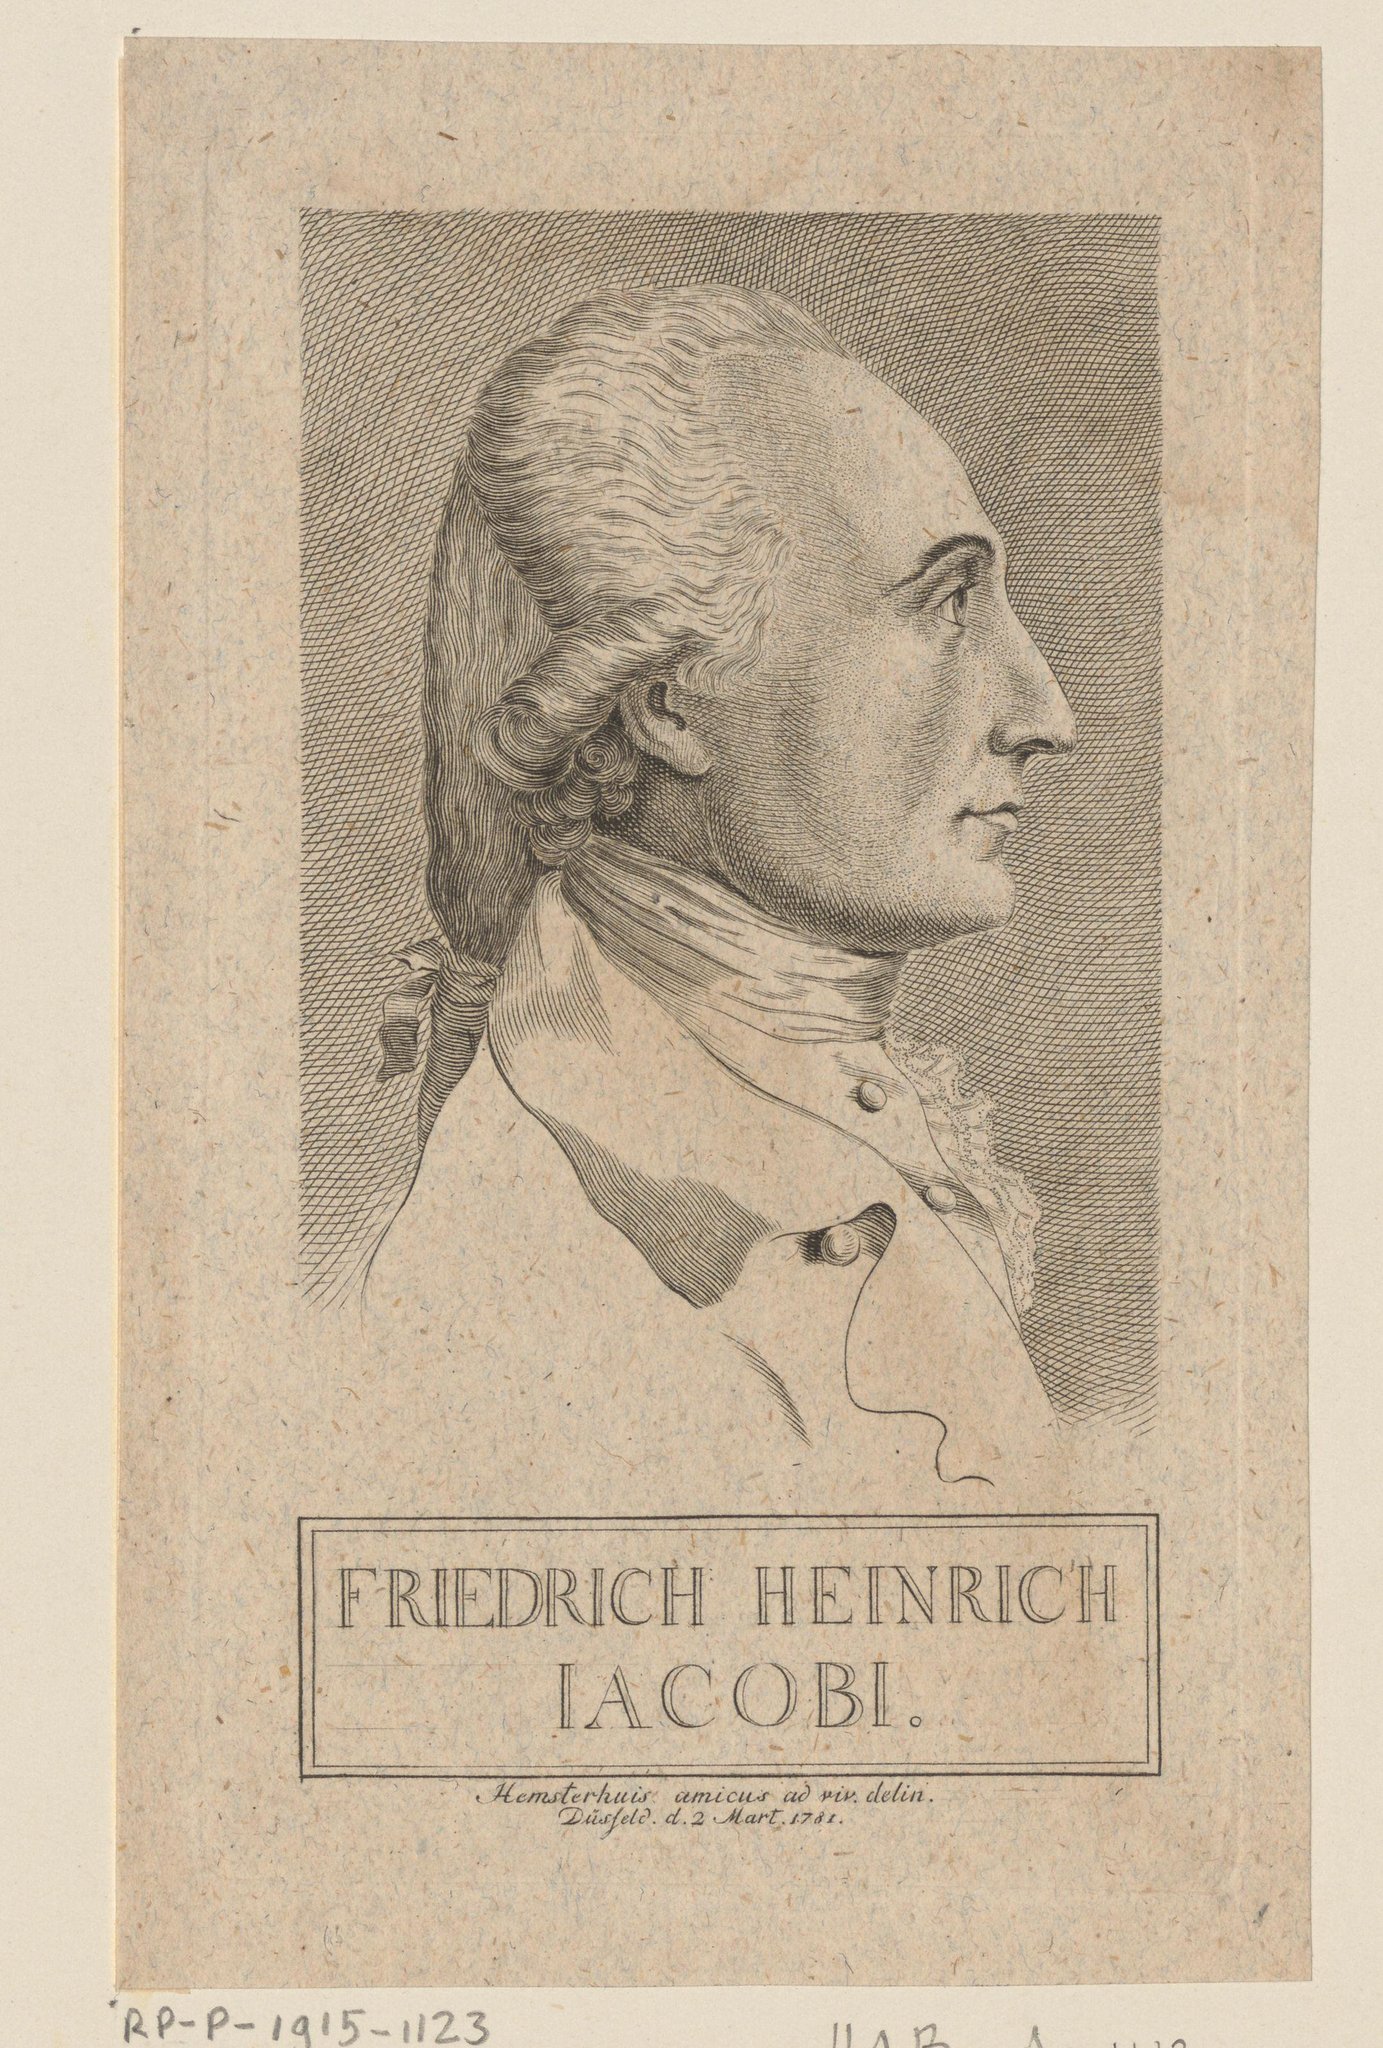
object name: print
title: Portret van Friedrich Heinrich Jacobi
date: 1783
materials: paper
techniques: engraving, etching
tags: scholar, philosopher, historical persons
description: Prent mogelijk uit: Neue allgemeine Deutsche Bibliothek. Kiel: Carl Ernst Bohn, 1783, dl. 54.